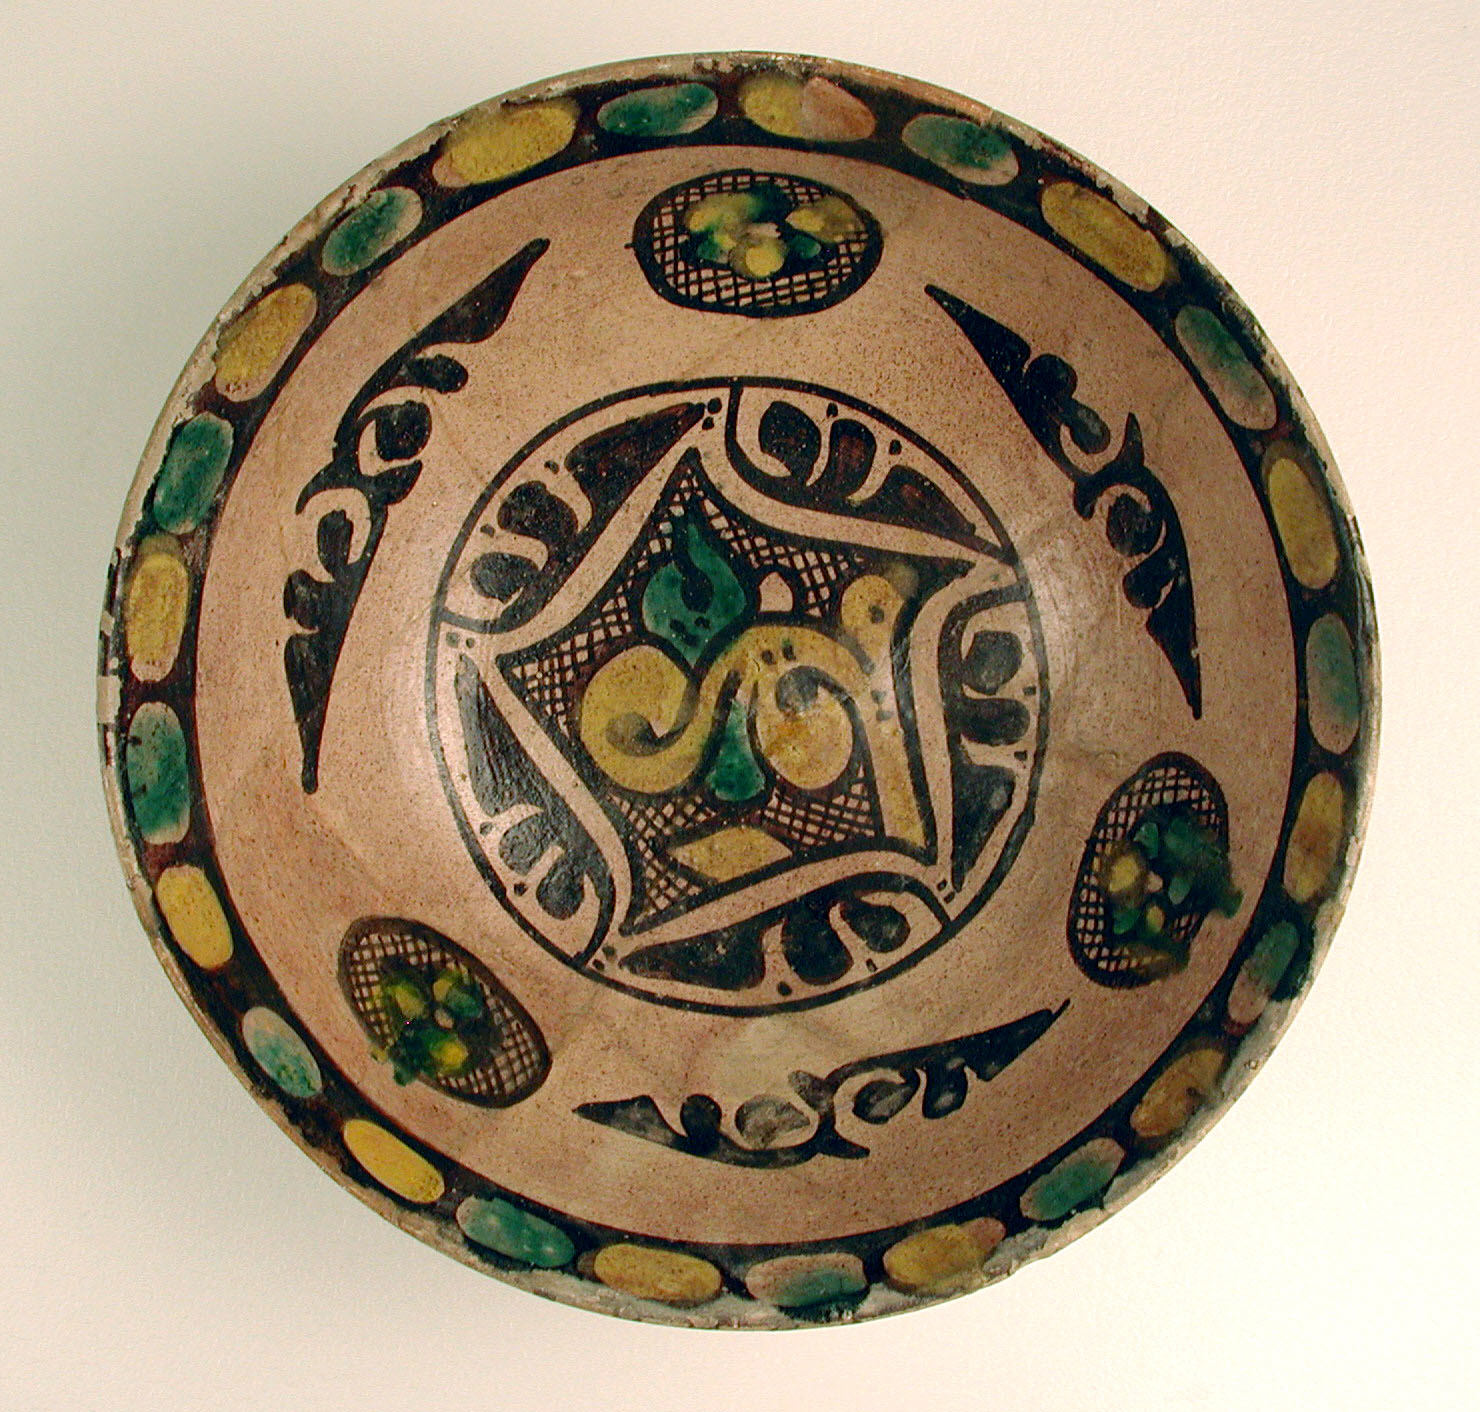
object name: bowl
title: Buffware Bowl with Geometric Designs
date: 767-833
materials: earthenware, glaze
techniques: polychrome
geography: iran